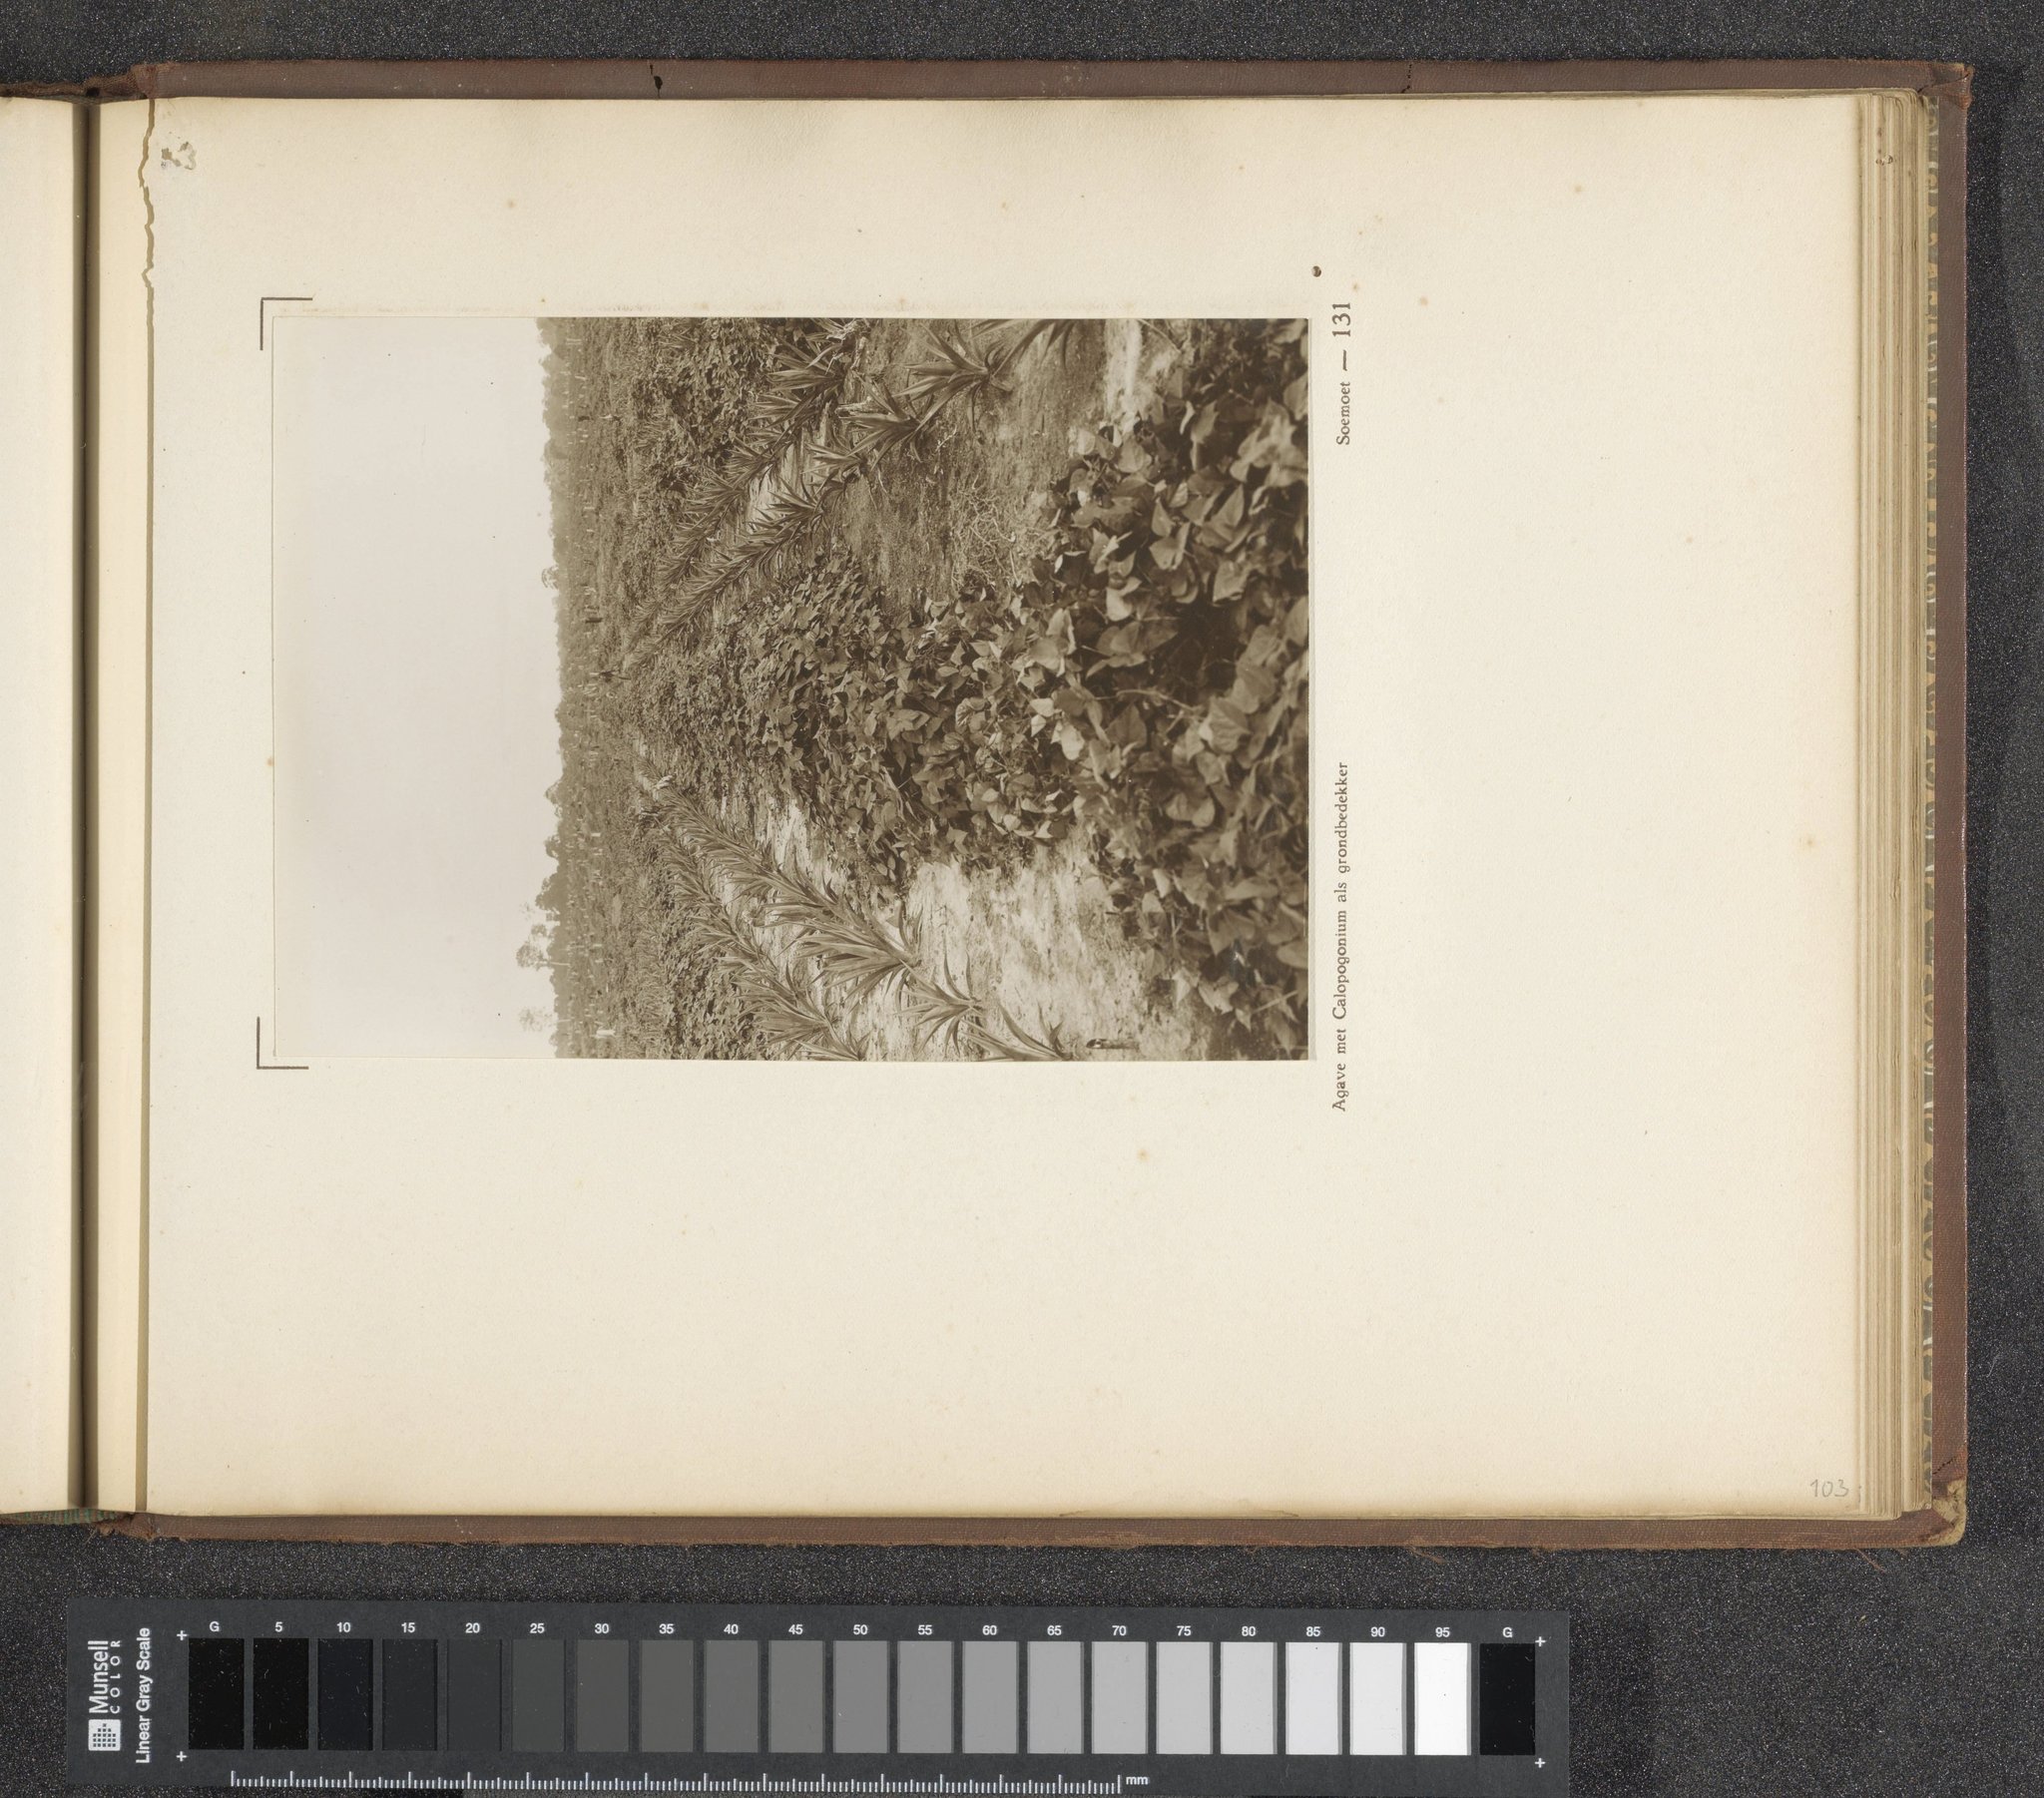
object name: album leaf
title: Pagina 131 van fotoboek van de Algemeene Vereeniging van Rubberplanters ter Oostkust van Sumatra (A.V.R.O.S.)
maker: j.w. meyster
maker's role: fotograaf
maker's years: 1887-1945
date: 1924-1925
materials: paper, photographic support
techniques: printing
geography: sumatra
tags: field filled with a crop, plants; vegetation, (non-fruit) products of plants or trees: rubber, sumatra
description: Boekpagina met een foto van een veld met agaveplanten op een plantage te Soemoet. Onderdeel van een fotoboek van de Algemeene Vereeniging van Rubberplanters ter Oostkust van Sumatra (A.V.R.O.S.).